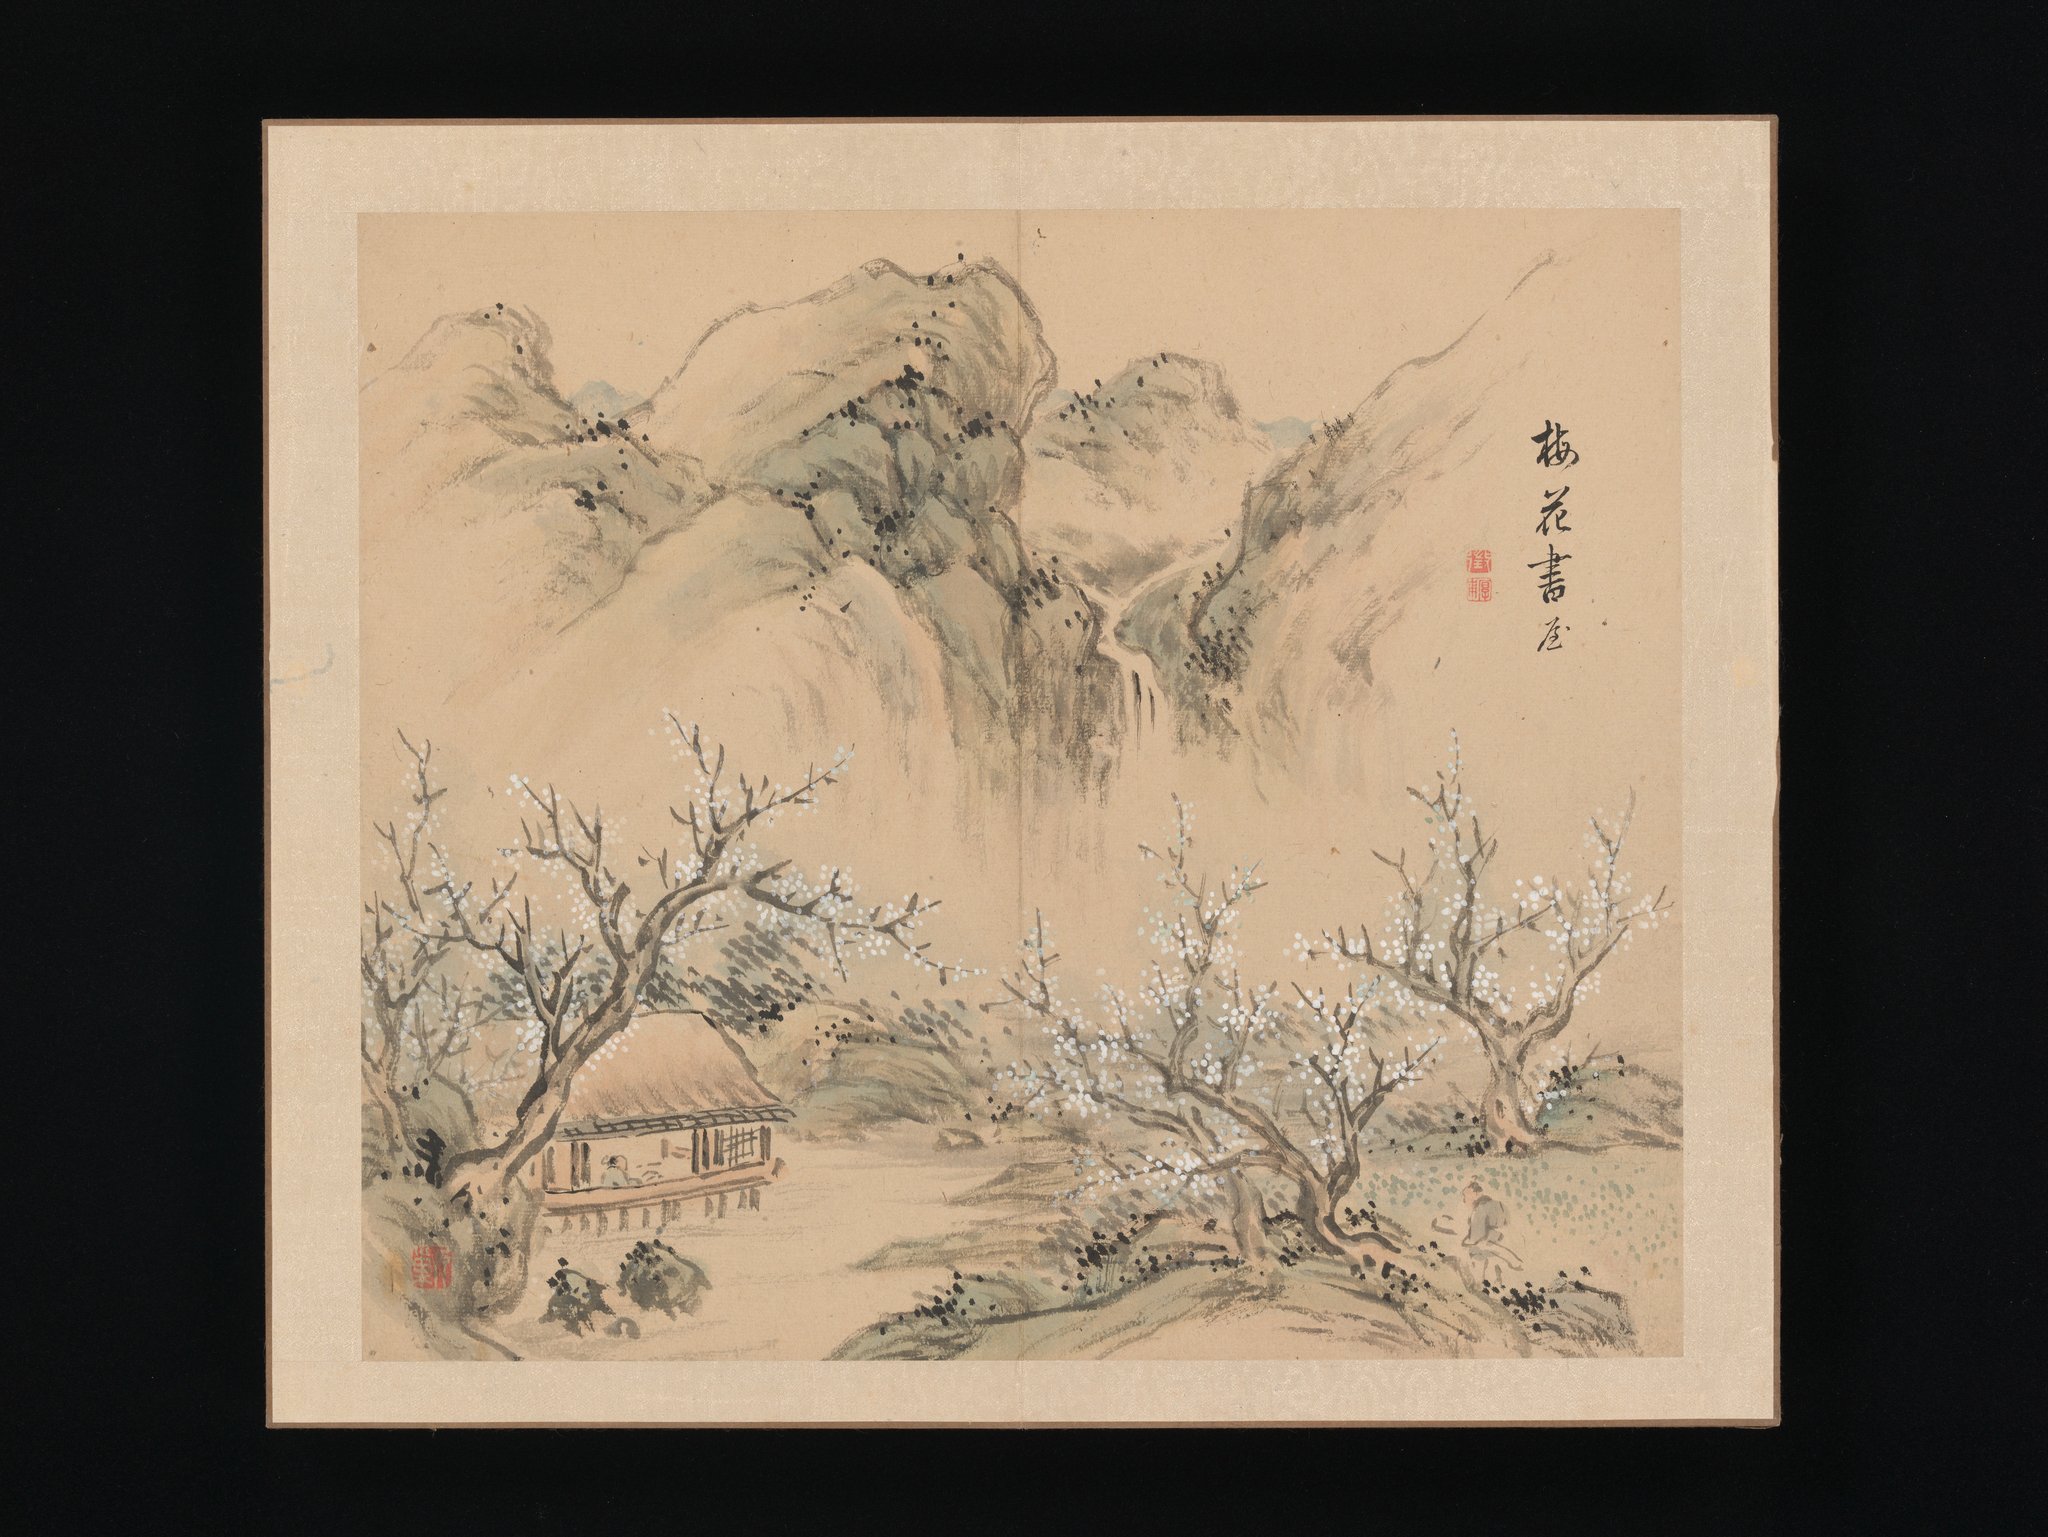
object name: album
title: Landscapes of the Four Seasons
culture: japanese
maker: takaku aigai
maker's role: artist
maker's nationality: japanese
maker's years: 1796-1843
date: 1833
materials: ink, paper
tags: mountains,landscapes